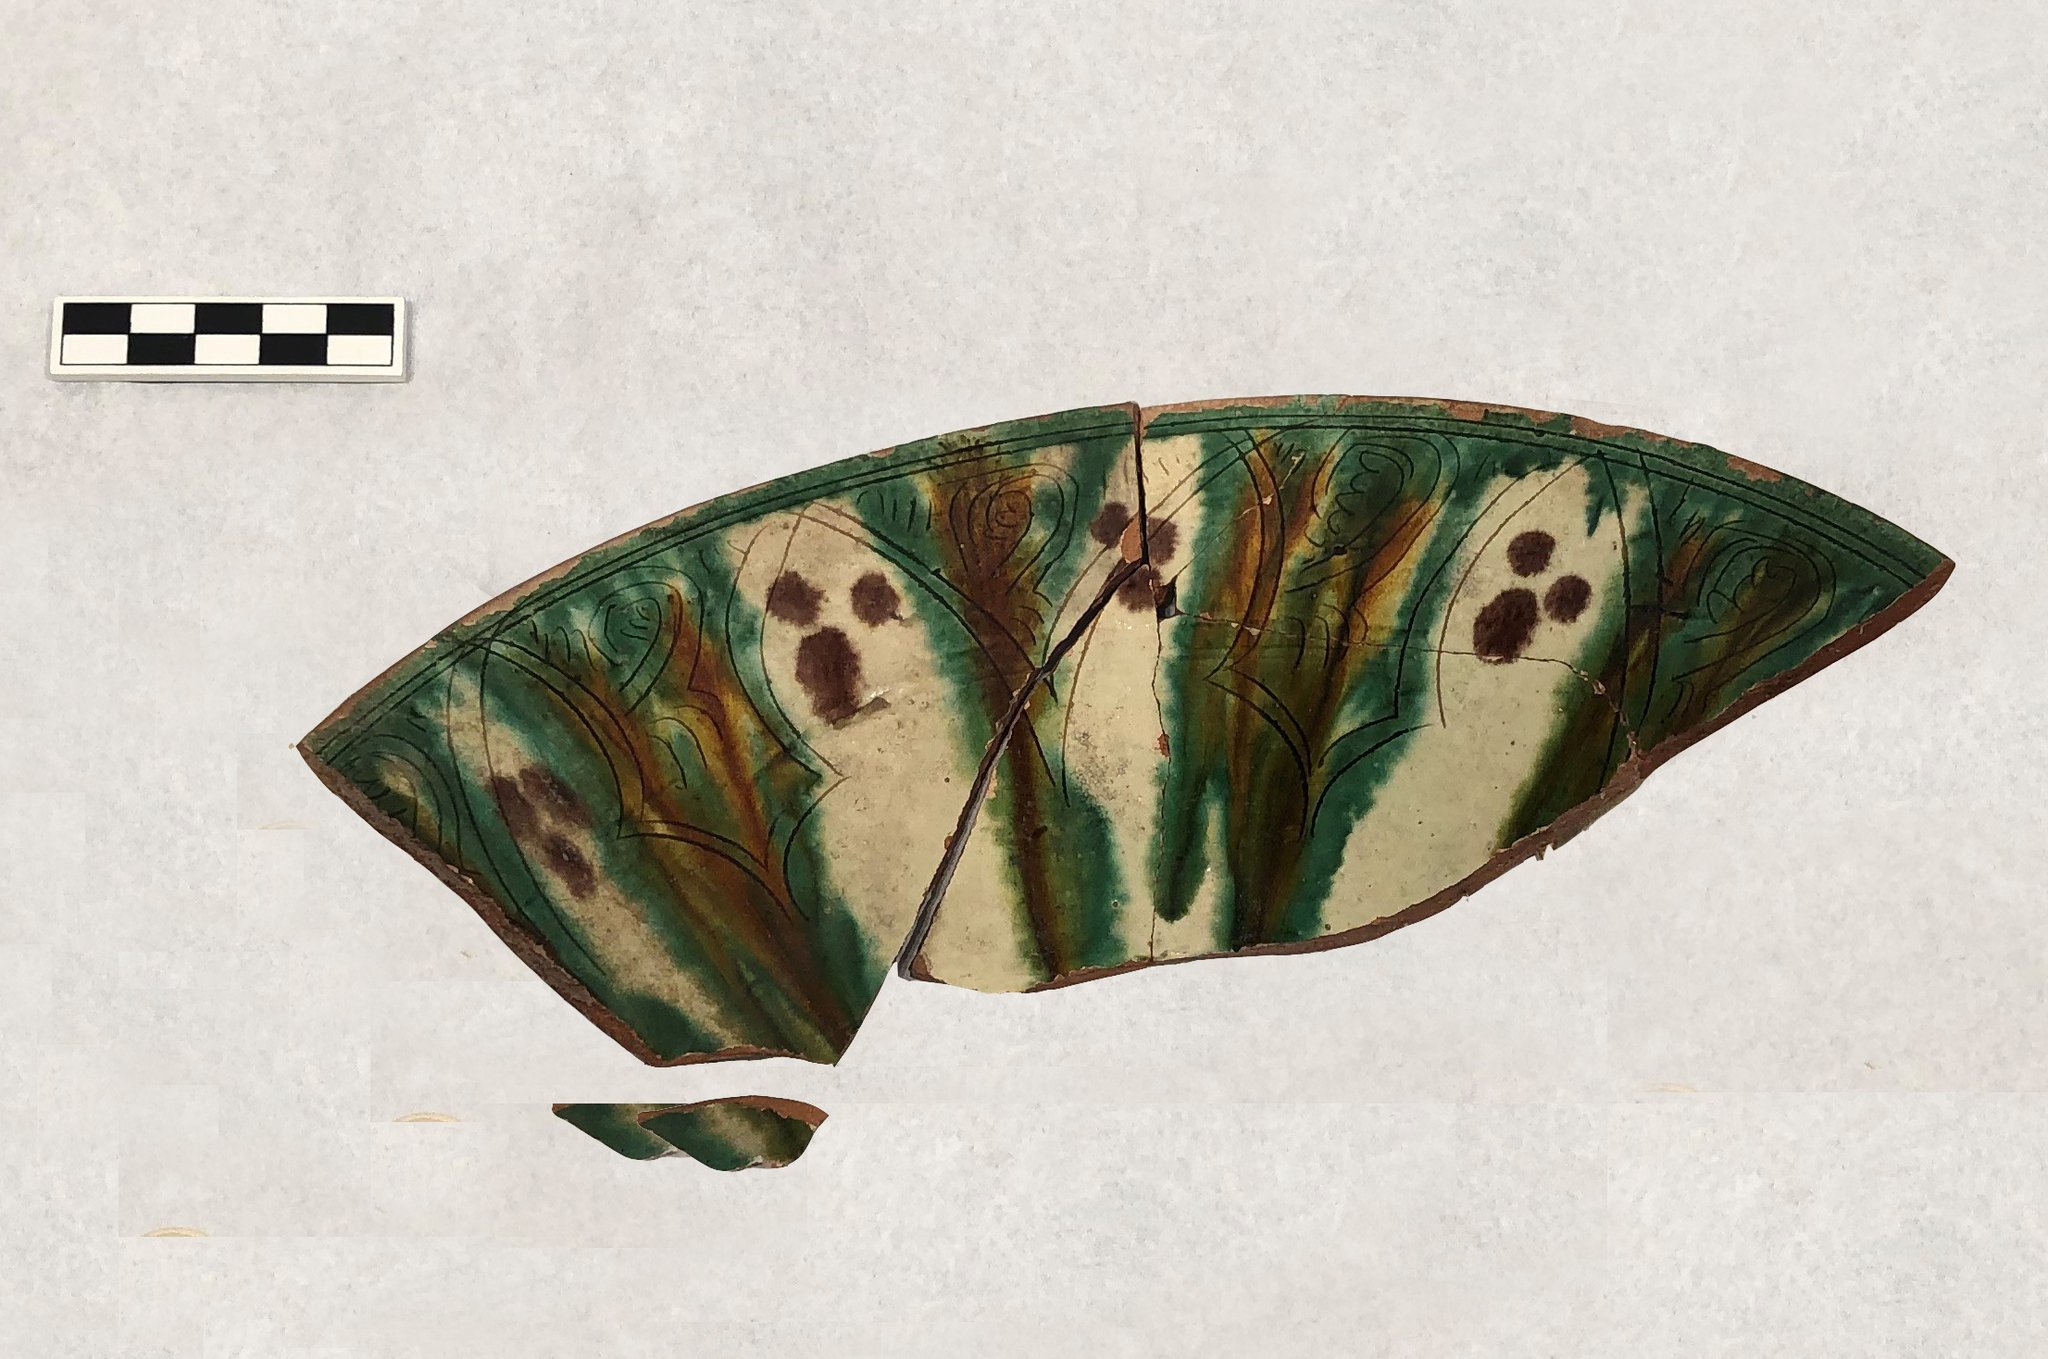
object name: fragment of a bowl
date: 801-900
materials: earthenware, glaze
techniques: incising, polychrome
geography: iran